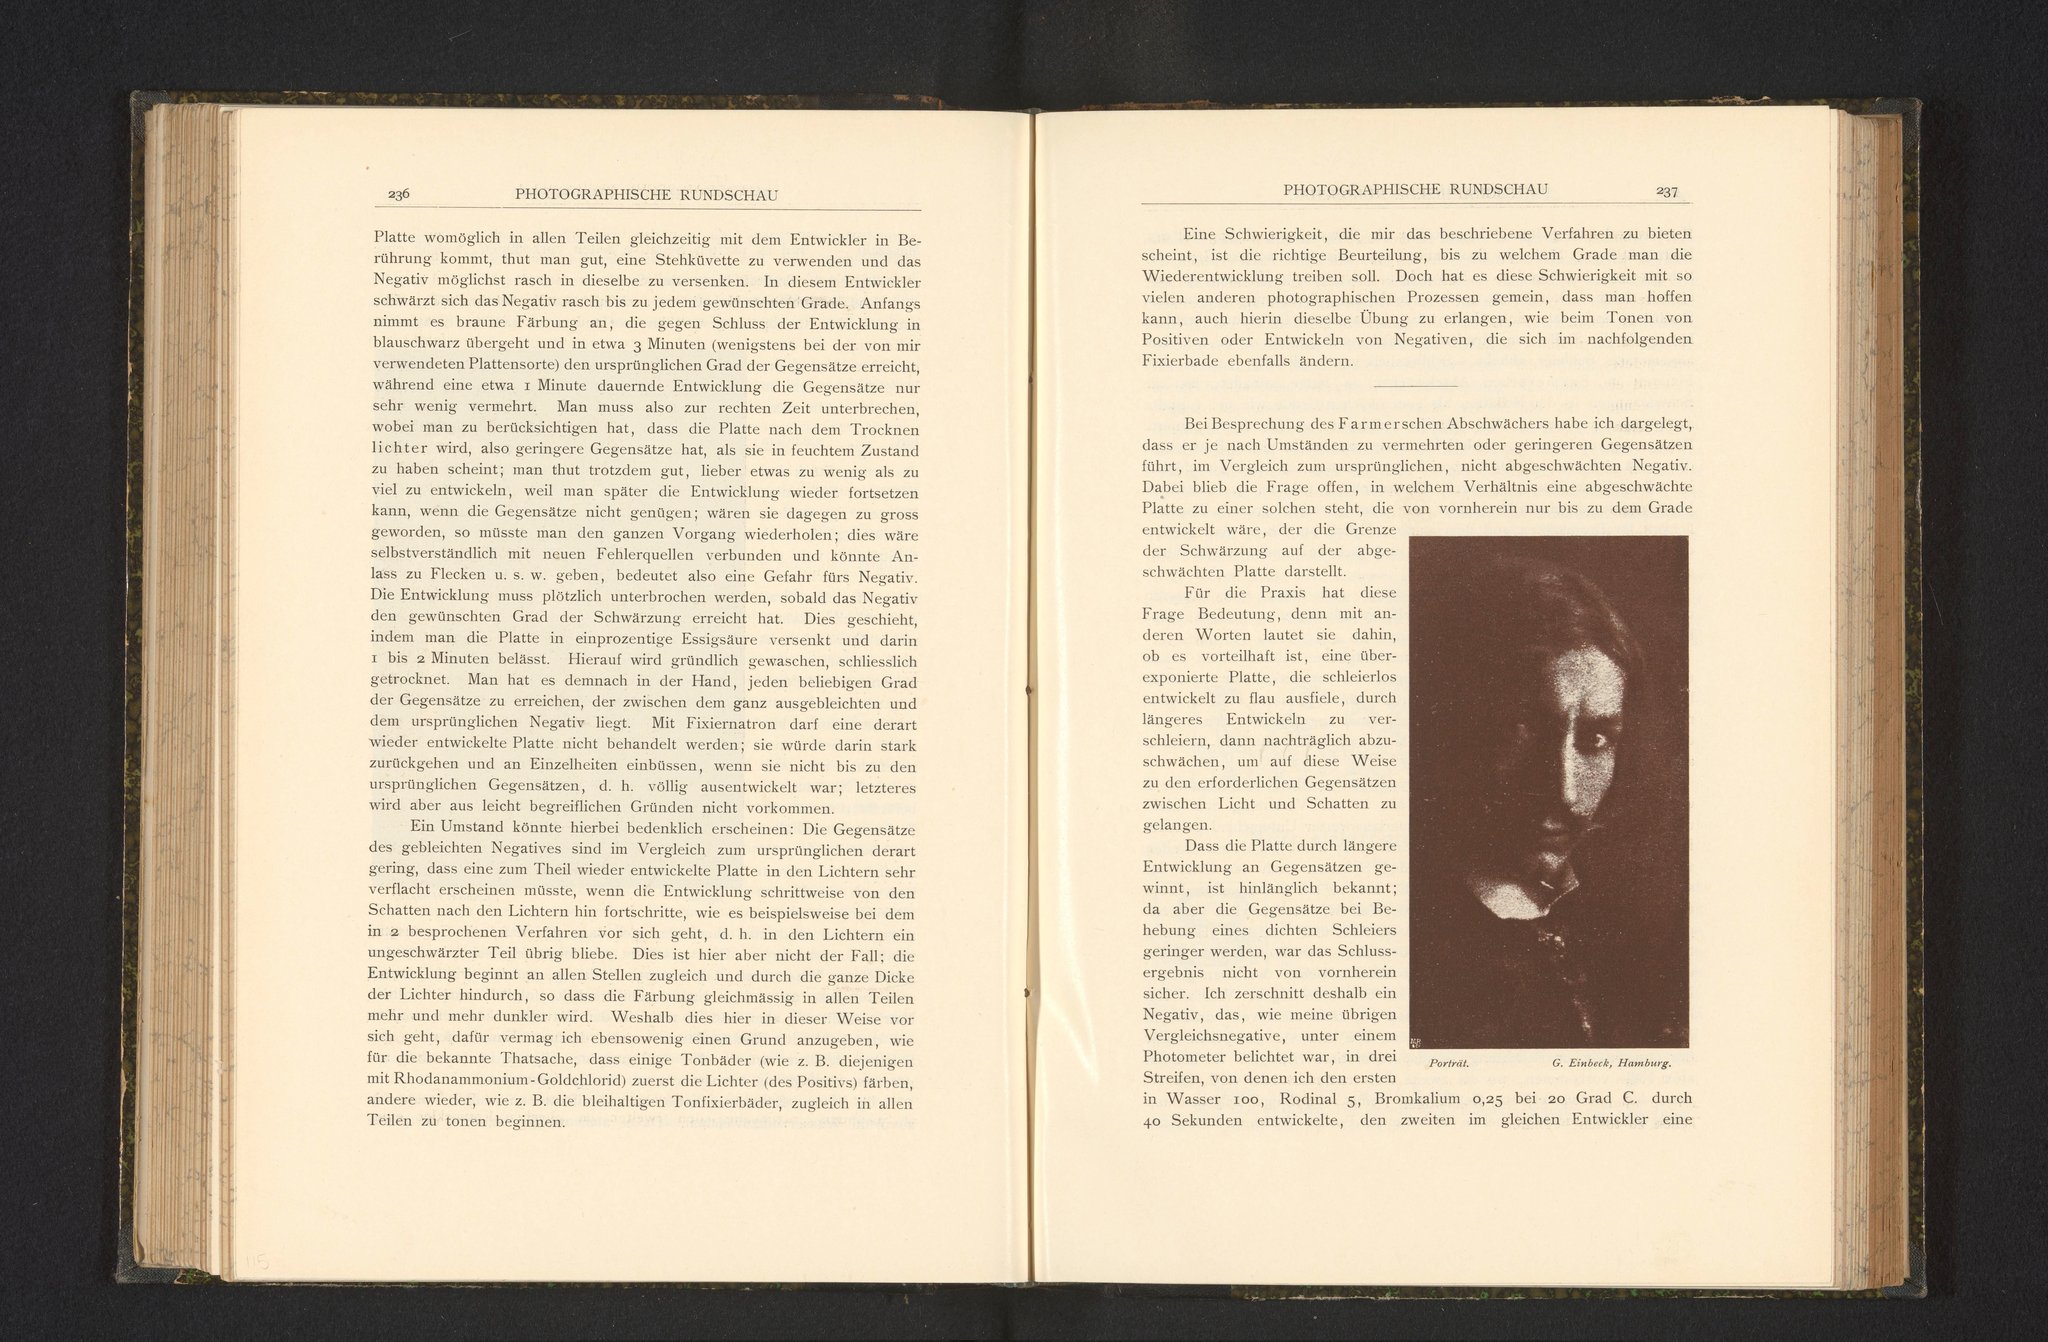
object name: photomechanical print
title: Porträt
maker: george einbeck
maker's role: painter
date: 1893-1898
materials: paper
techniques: autotype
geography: berlin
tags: adult man, anonymous historical person portrayed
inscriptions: monogram: ‘MR/ &Co’